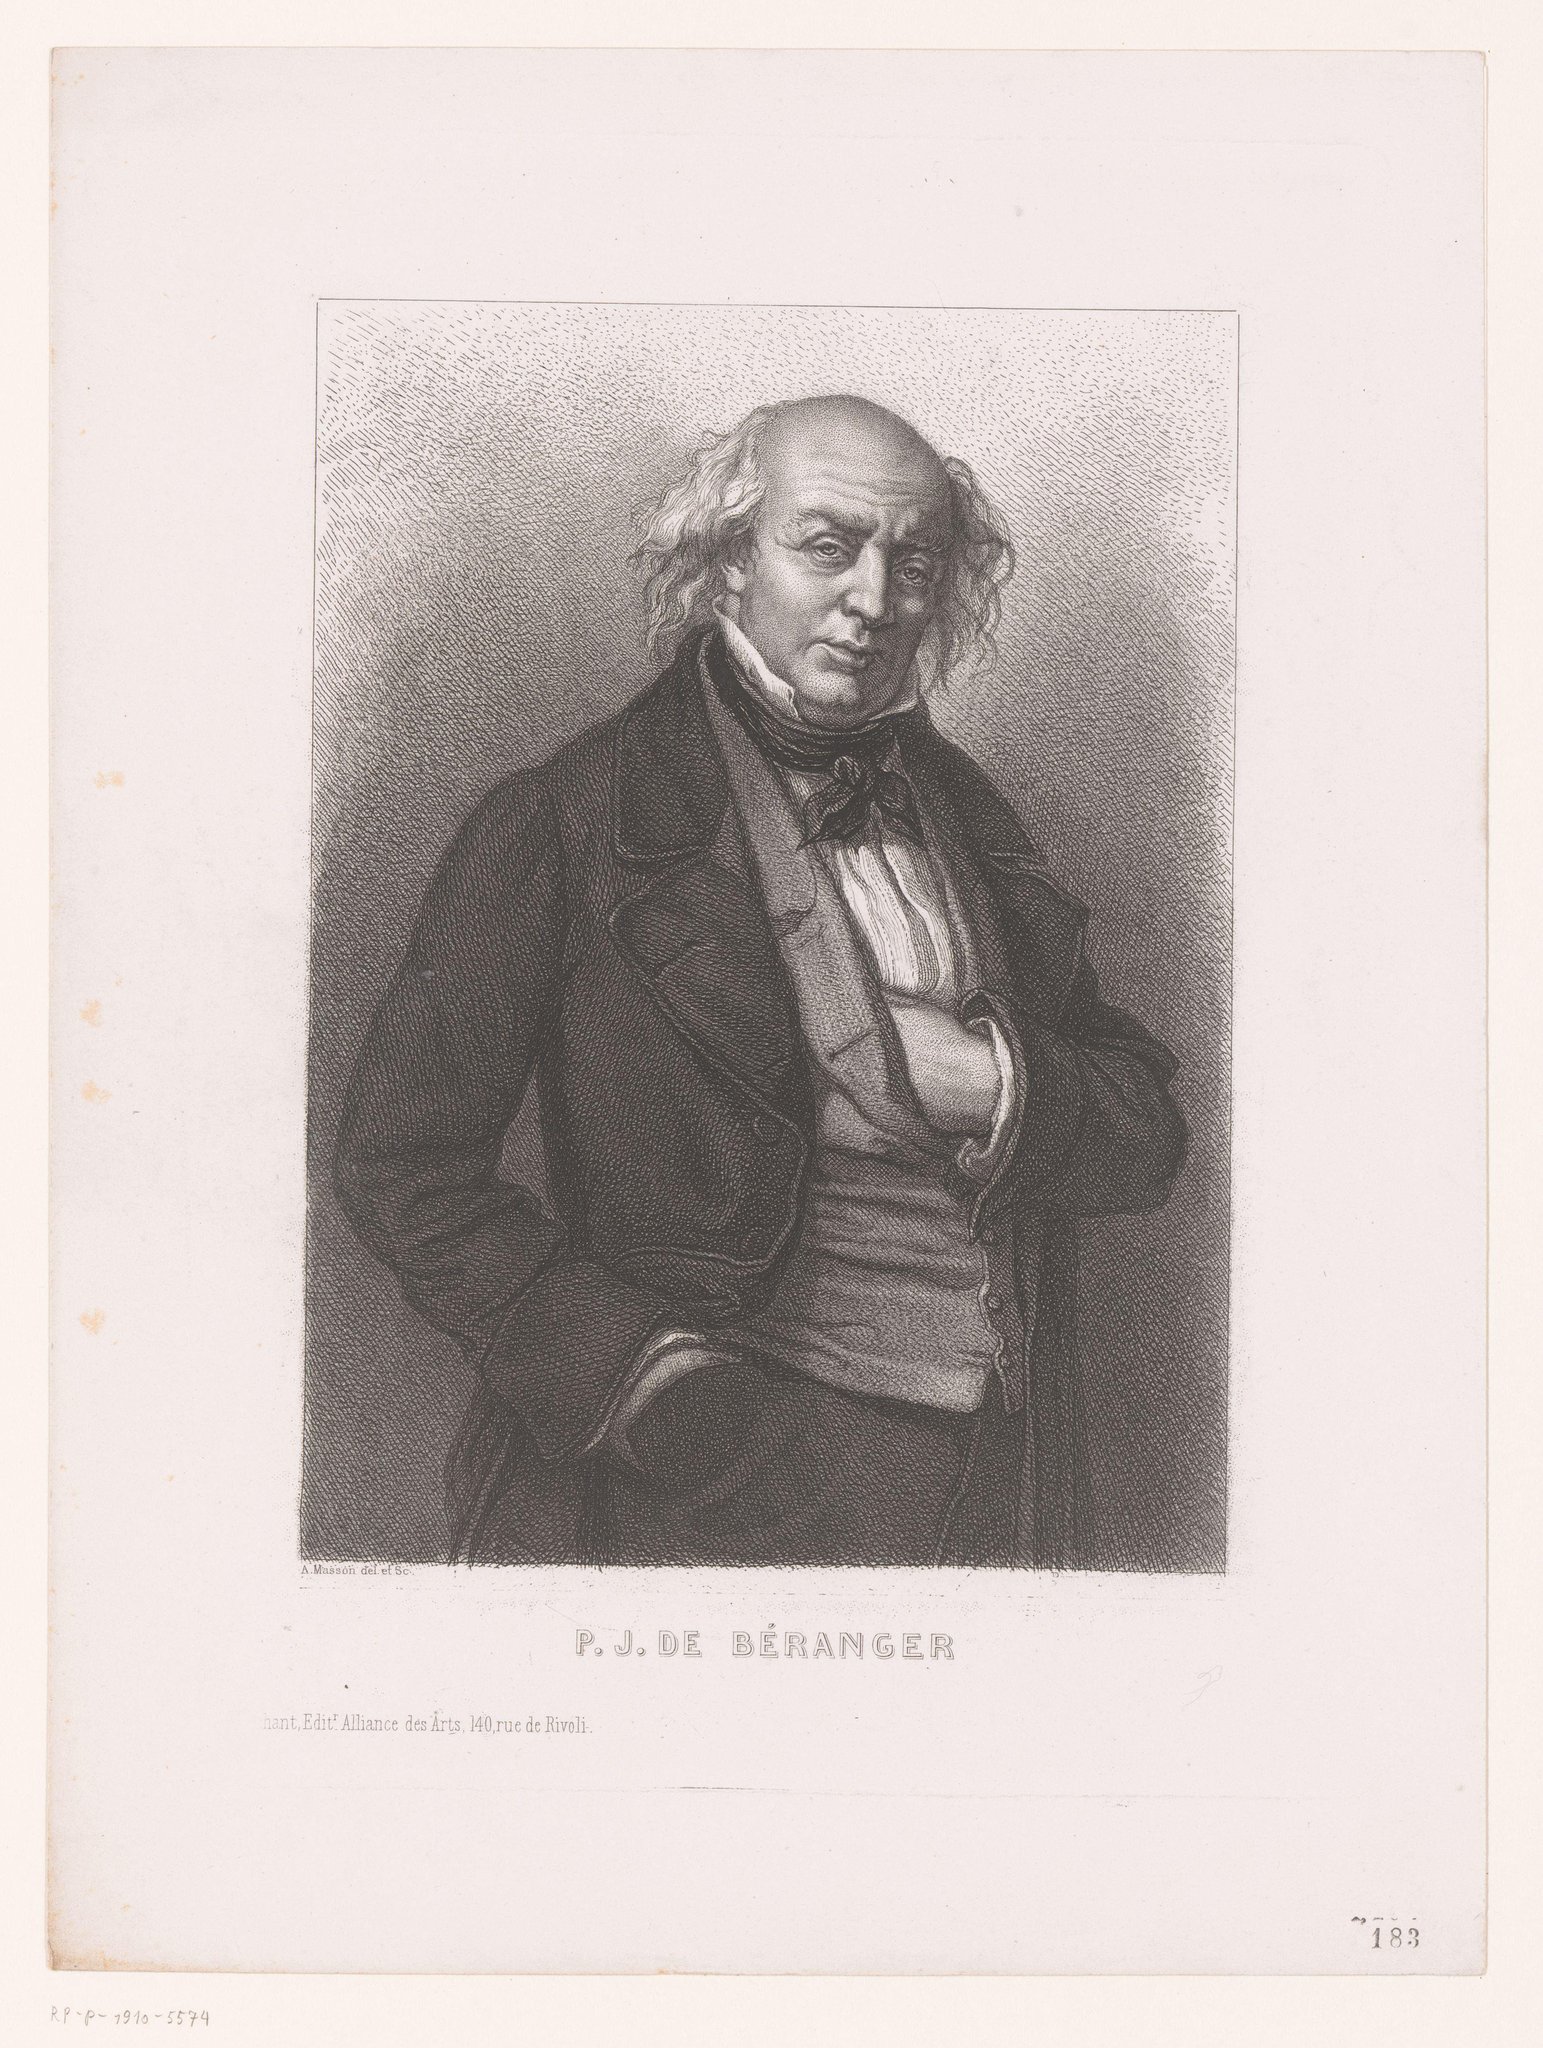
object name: print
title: Portret van Pierre-Jean de Béranger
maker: alphonse charles masson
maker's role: print maker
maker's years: 1814-1898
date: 1824-1898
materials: paper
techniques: engraving, etching, roulette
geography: paris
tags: paris, pierre-jean de béranger, historical persons, portrait of a writer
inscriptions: collector's mark: Lugt 2228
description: Gepubliceerd in: l'Artiste, in of na 1849.